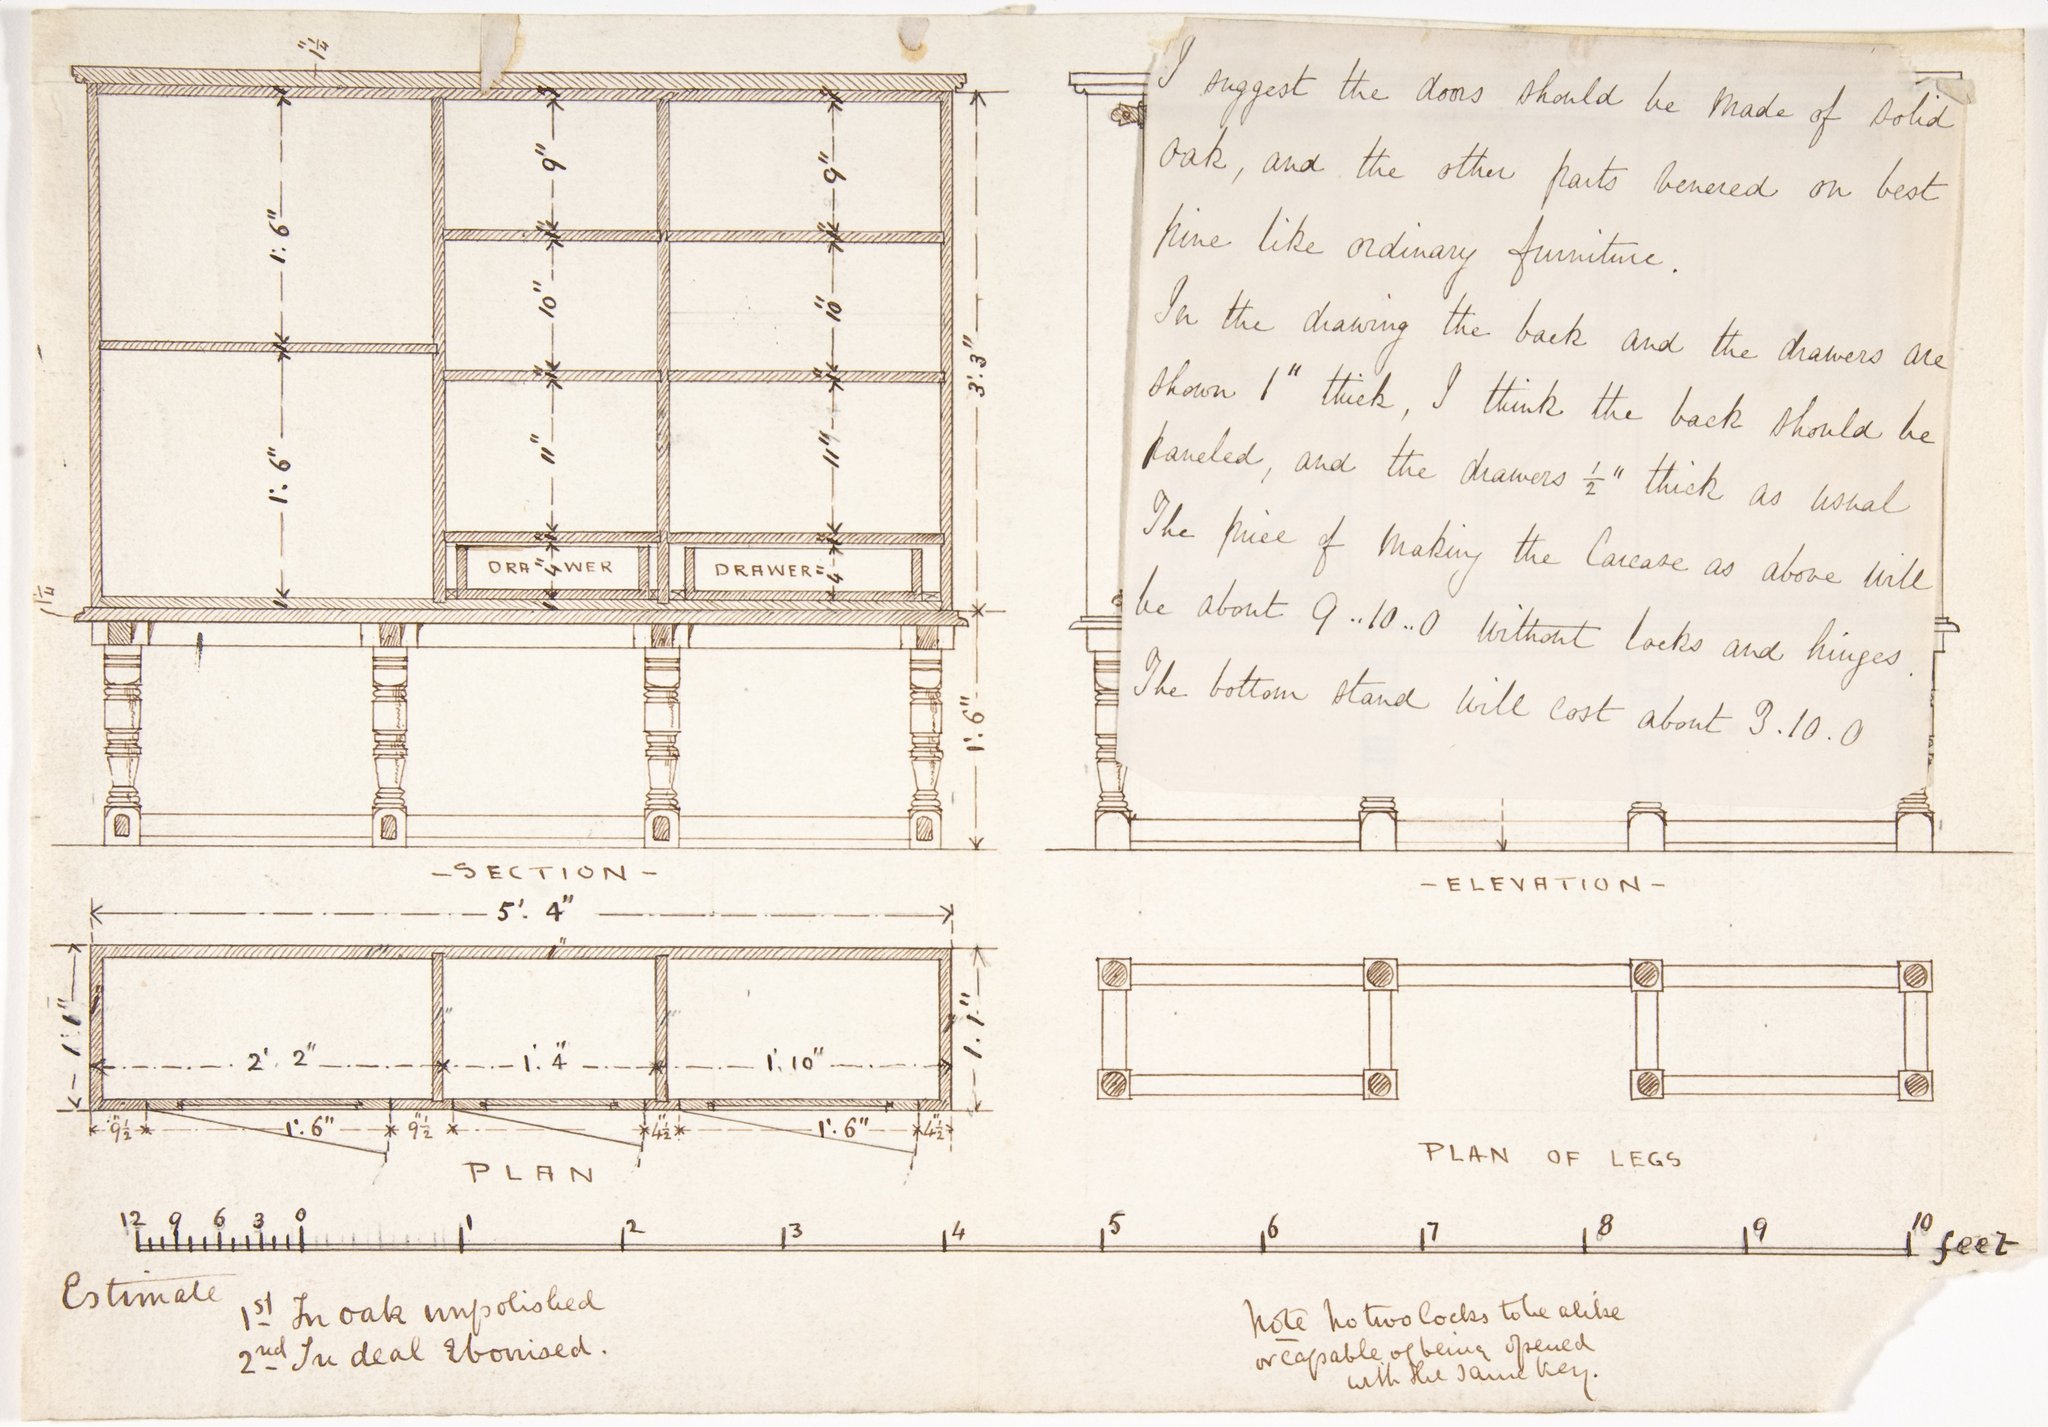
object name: drawing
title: Design for a Wood Desk and Shelves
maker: anonymous, british, 19th century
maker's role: artist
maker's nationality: british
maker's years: 1800-1900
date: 1830-1900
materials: ink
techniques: pen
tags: desks